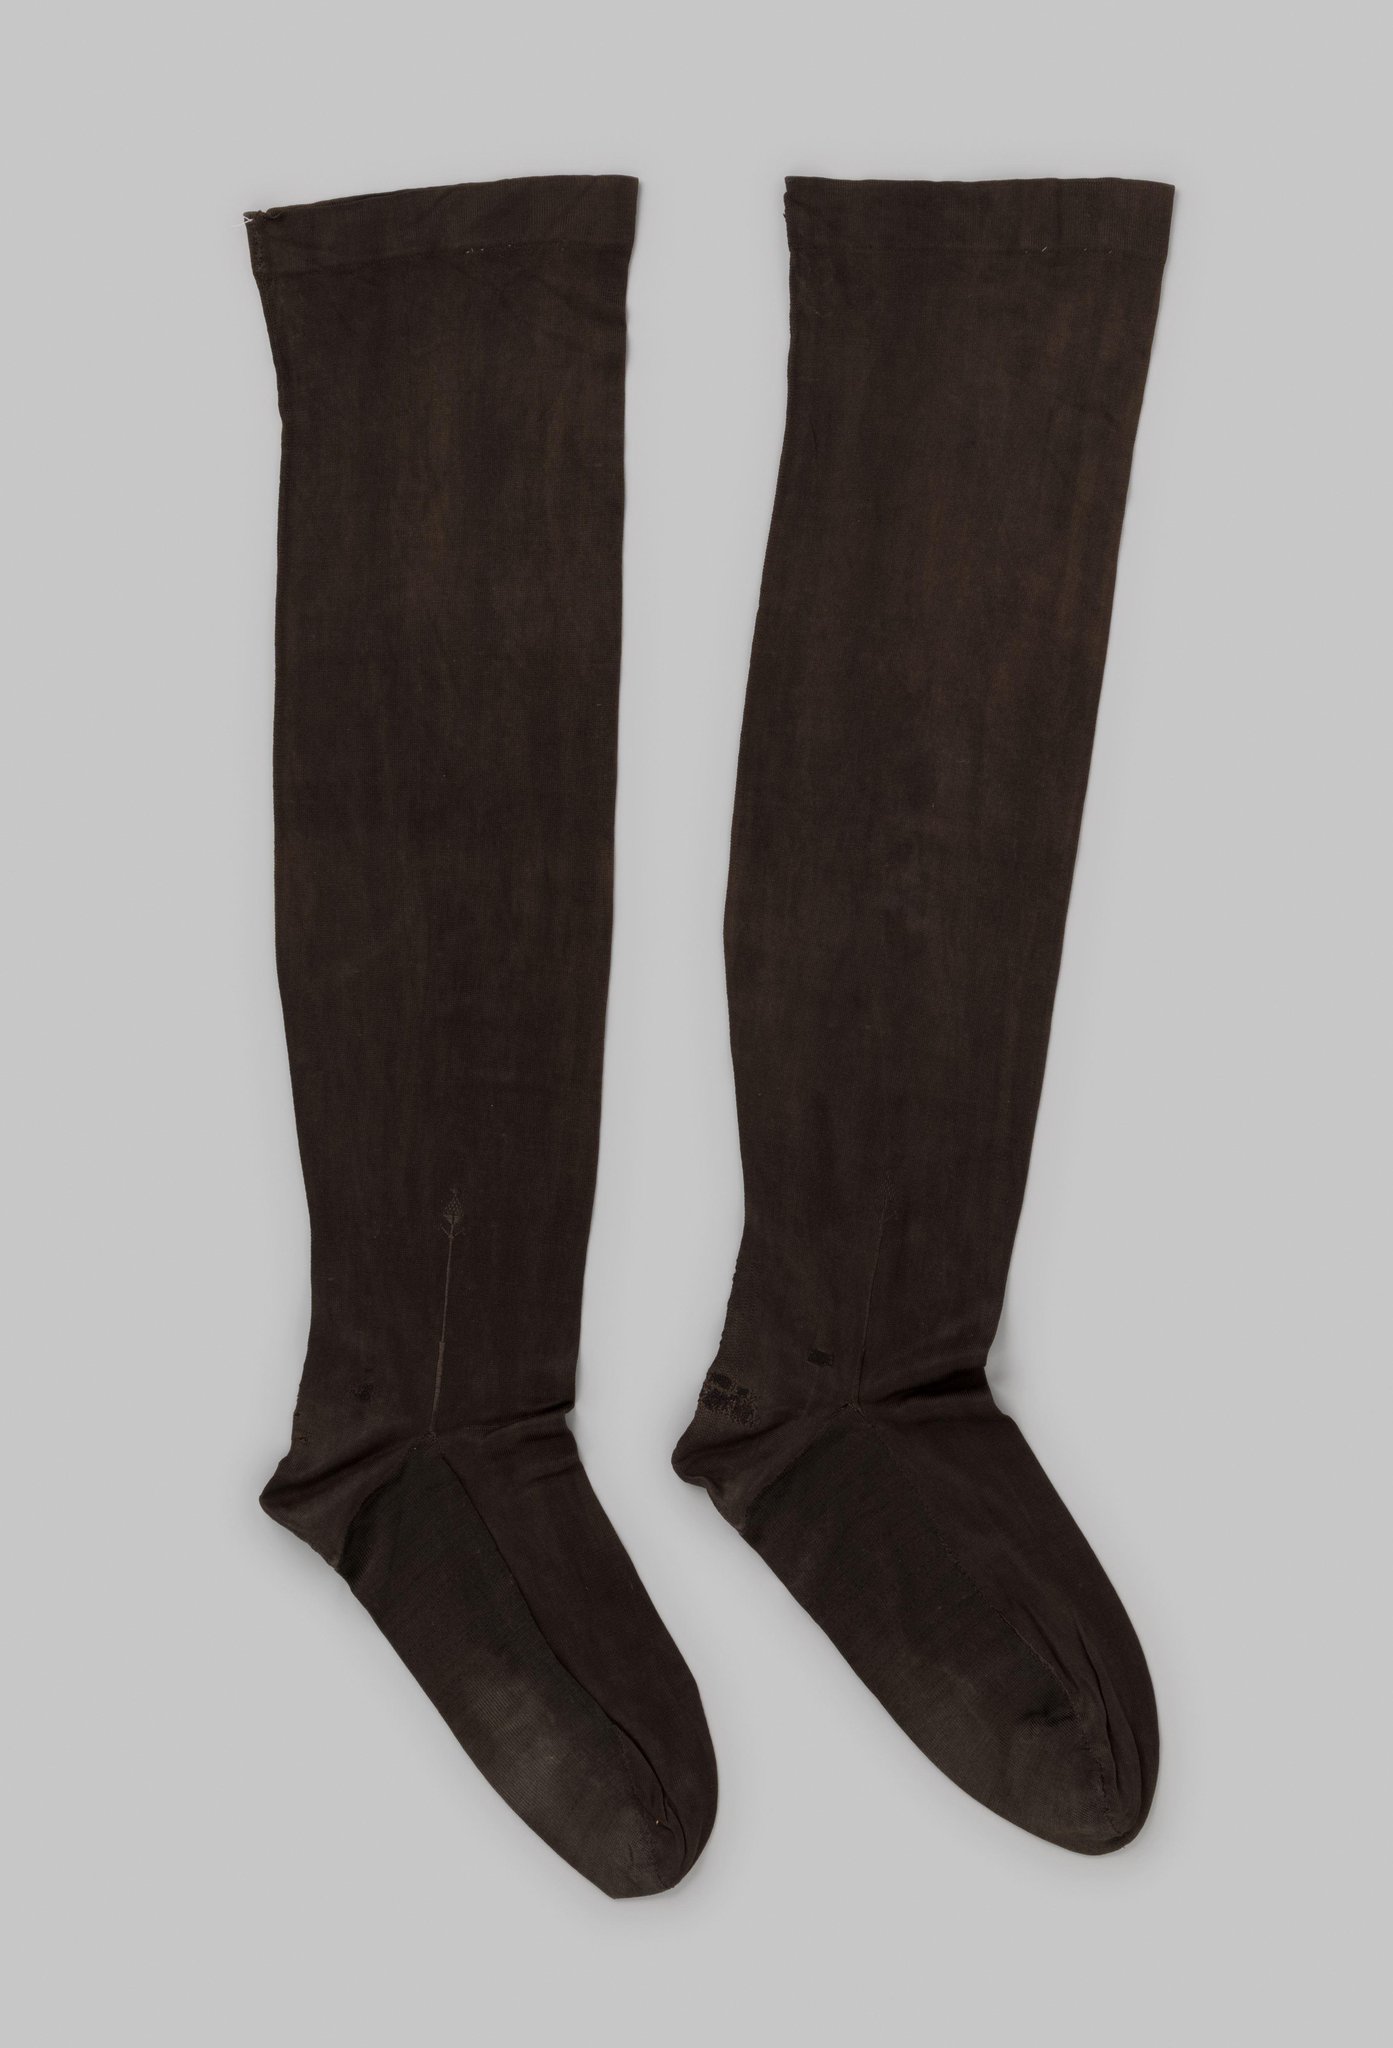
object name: stocking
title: Kous van donkerbruine zijde met pijlvormige versiering op de klink en ingezet katoenen voetstuk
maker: Anonymous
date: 1800-1820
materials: cotton, silk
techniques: knitting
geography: france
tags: vught, overveen, minister, staatsman, intendant-generaal van financien, secretaris van staat voor financien, minister van financiën, izaak jean alexandre gogel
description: Kous van donkerbruine zijde met pijlvormige versiering op de klink en ingezet katoenen voetstuk. Naad middenachter.